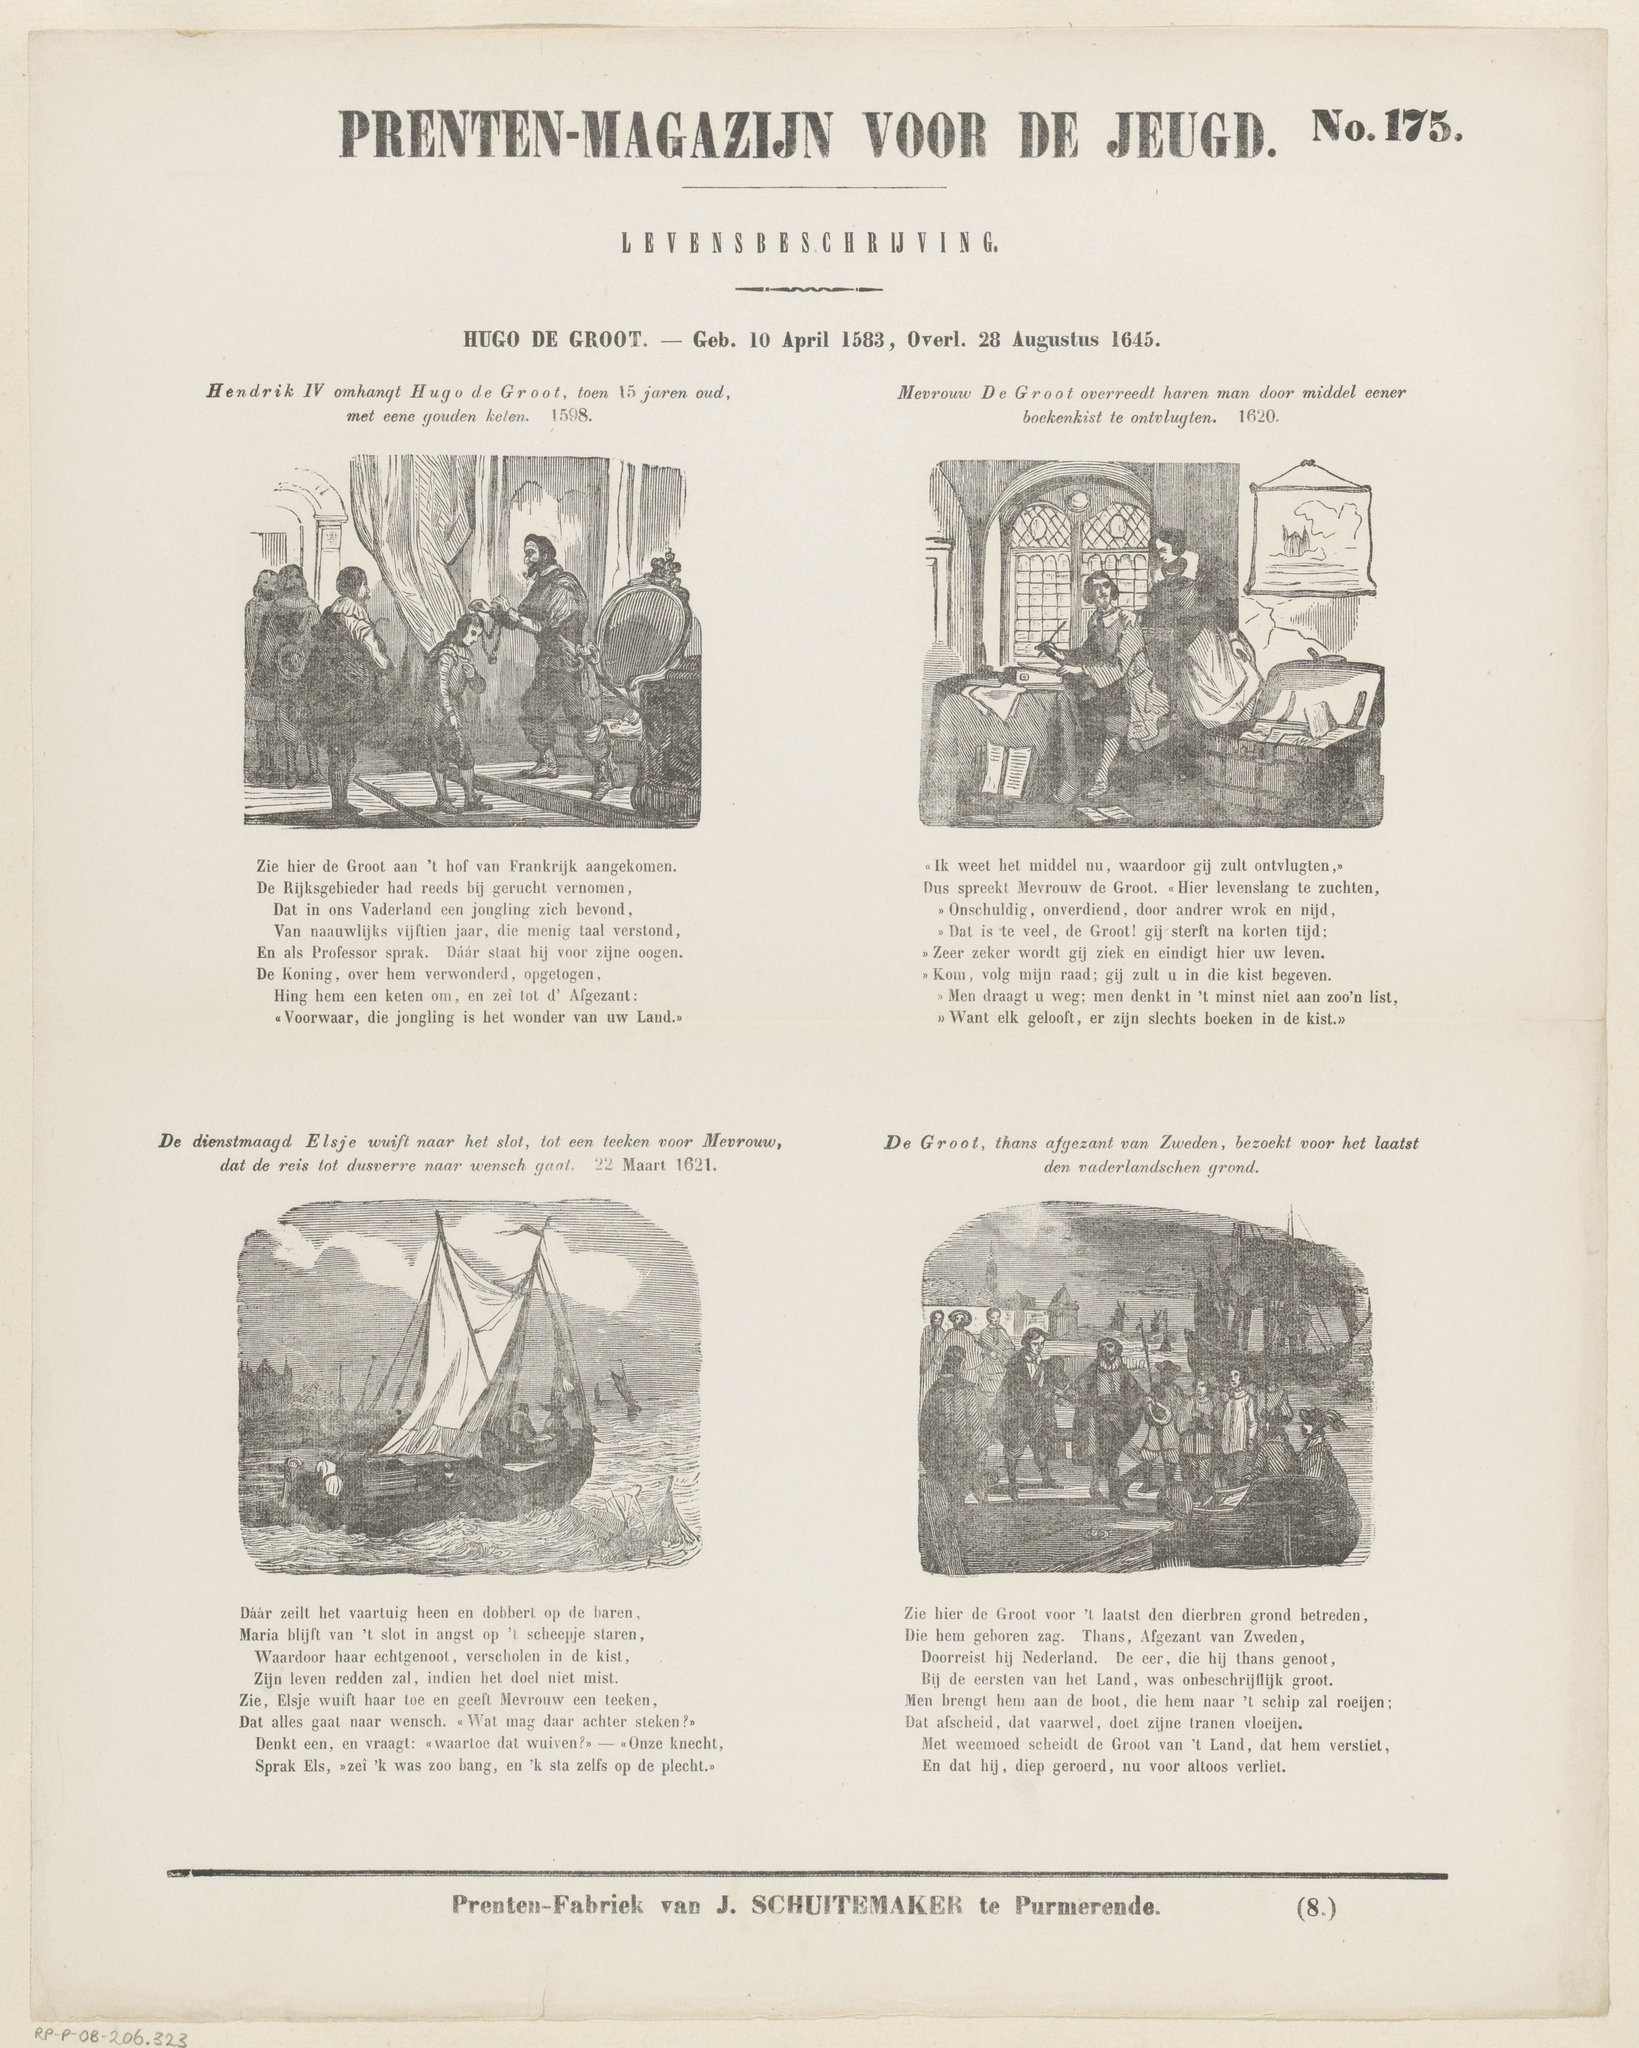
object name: popular print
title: Prenten-magazijn voor de jeugd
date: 1850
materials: paper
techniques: letterpress printing, engraving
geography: netherlands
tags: delft, hugo de groot, historical persons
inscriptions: collector's mark: Lugt 2760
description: Na voltooiing van de acht jaargangen van de reeks 'Prenten-magazijn voor de jeugd' in 1850 heeft Jan Schuitemaker al deze prenten heruitgegeven en omgenummerd als nr. 1 t/m 192. De oorspronkelijke jaargang wordt telkens nog vermeld rechtsonder op de prent. Binnen de jaargangen zijn prenten van hetzelfde thema in clusters van vier achter elkaar gezet.